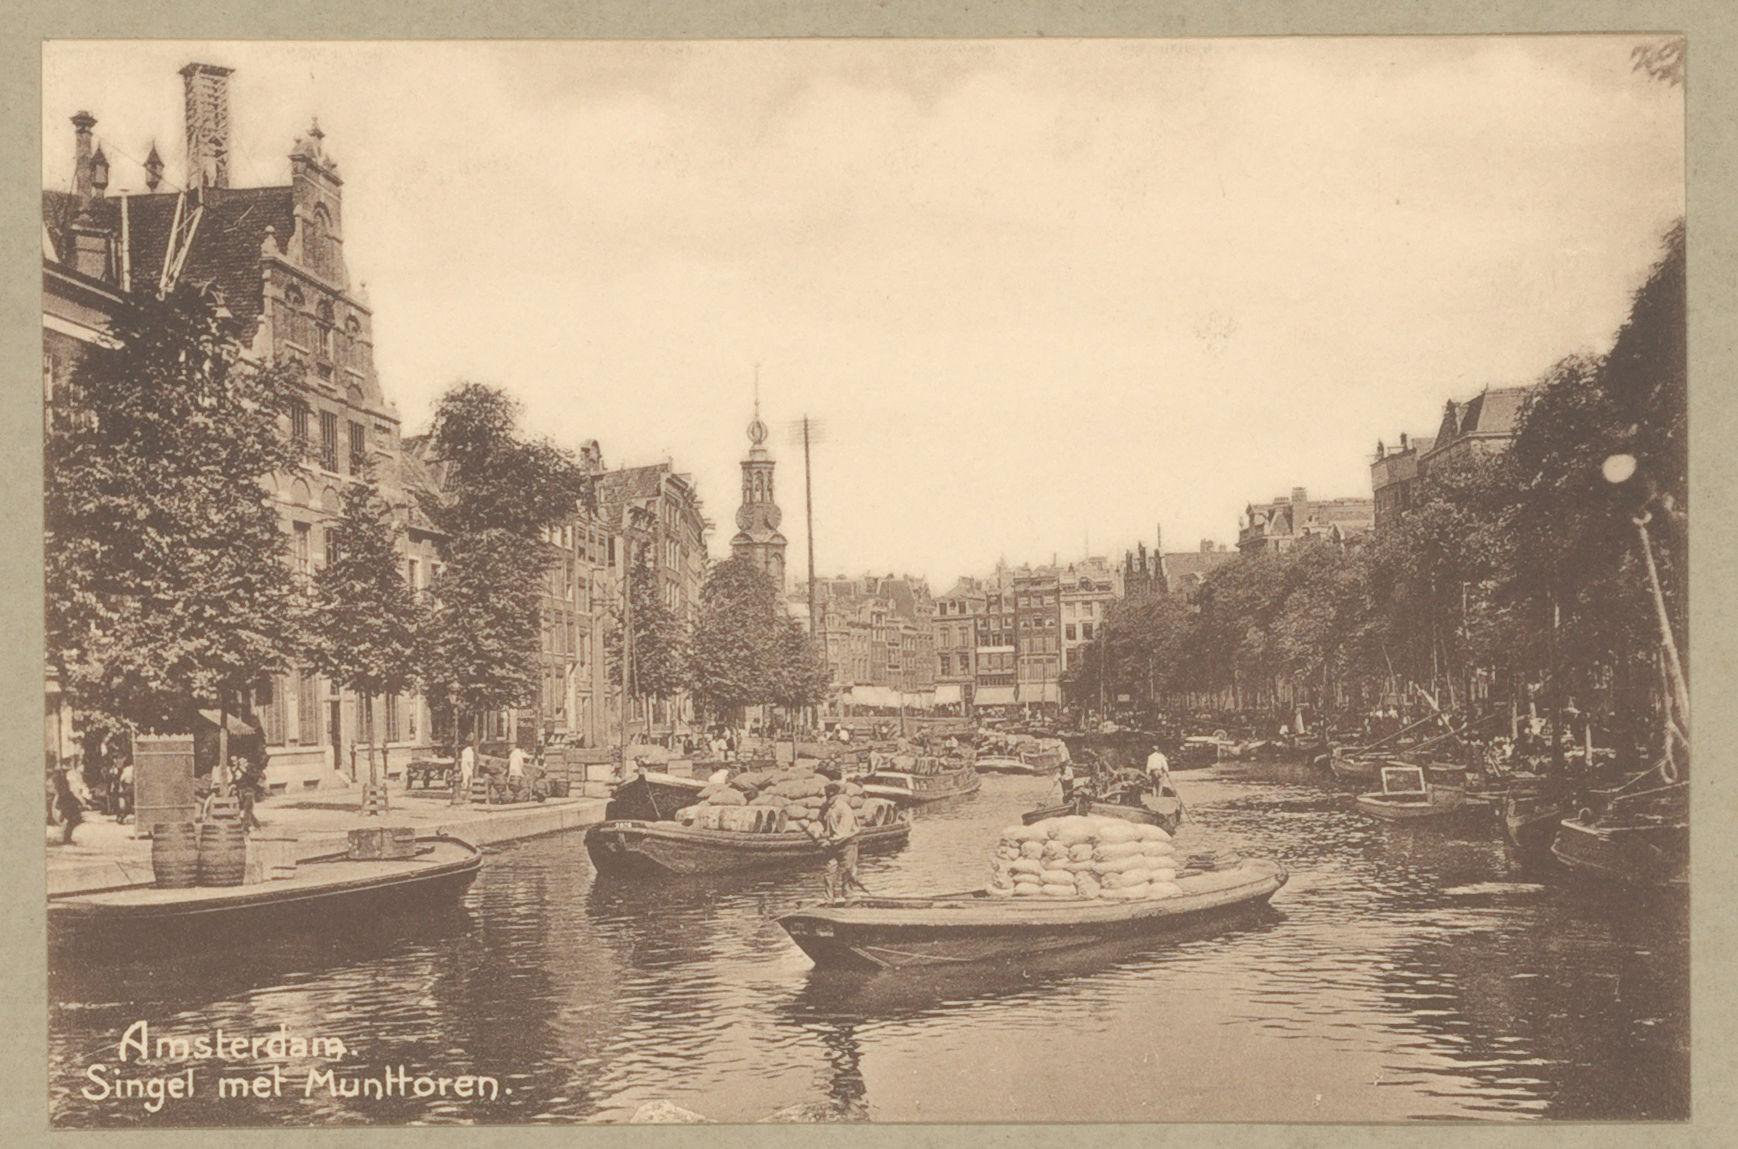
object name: photomechanical print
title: Gezicht op de Munttoren vanaf het Singel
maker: Anonymous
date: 1905-1930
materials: cardboard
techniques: photograph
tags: tower, clock tower ~ monumental adornment, city-view in general; 'veduta', canal, tow-boat, towing-barge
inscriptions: collector's mark: ‘13’ Lugt 1641b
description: Onderwerpsrubriek binnen de Atlas Amsterdam: Oude Schans, Schoutensteeg, Singel (Korte), Singel.